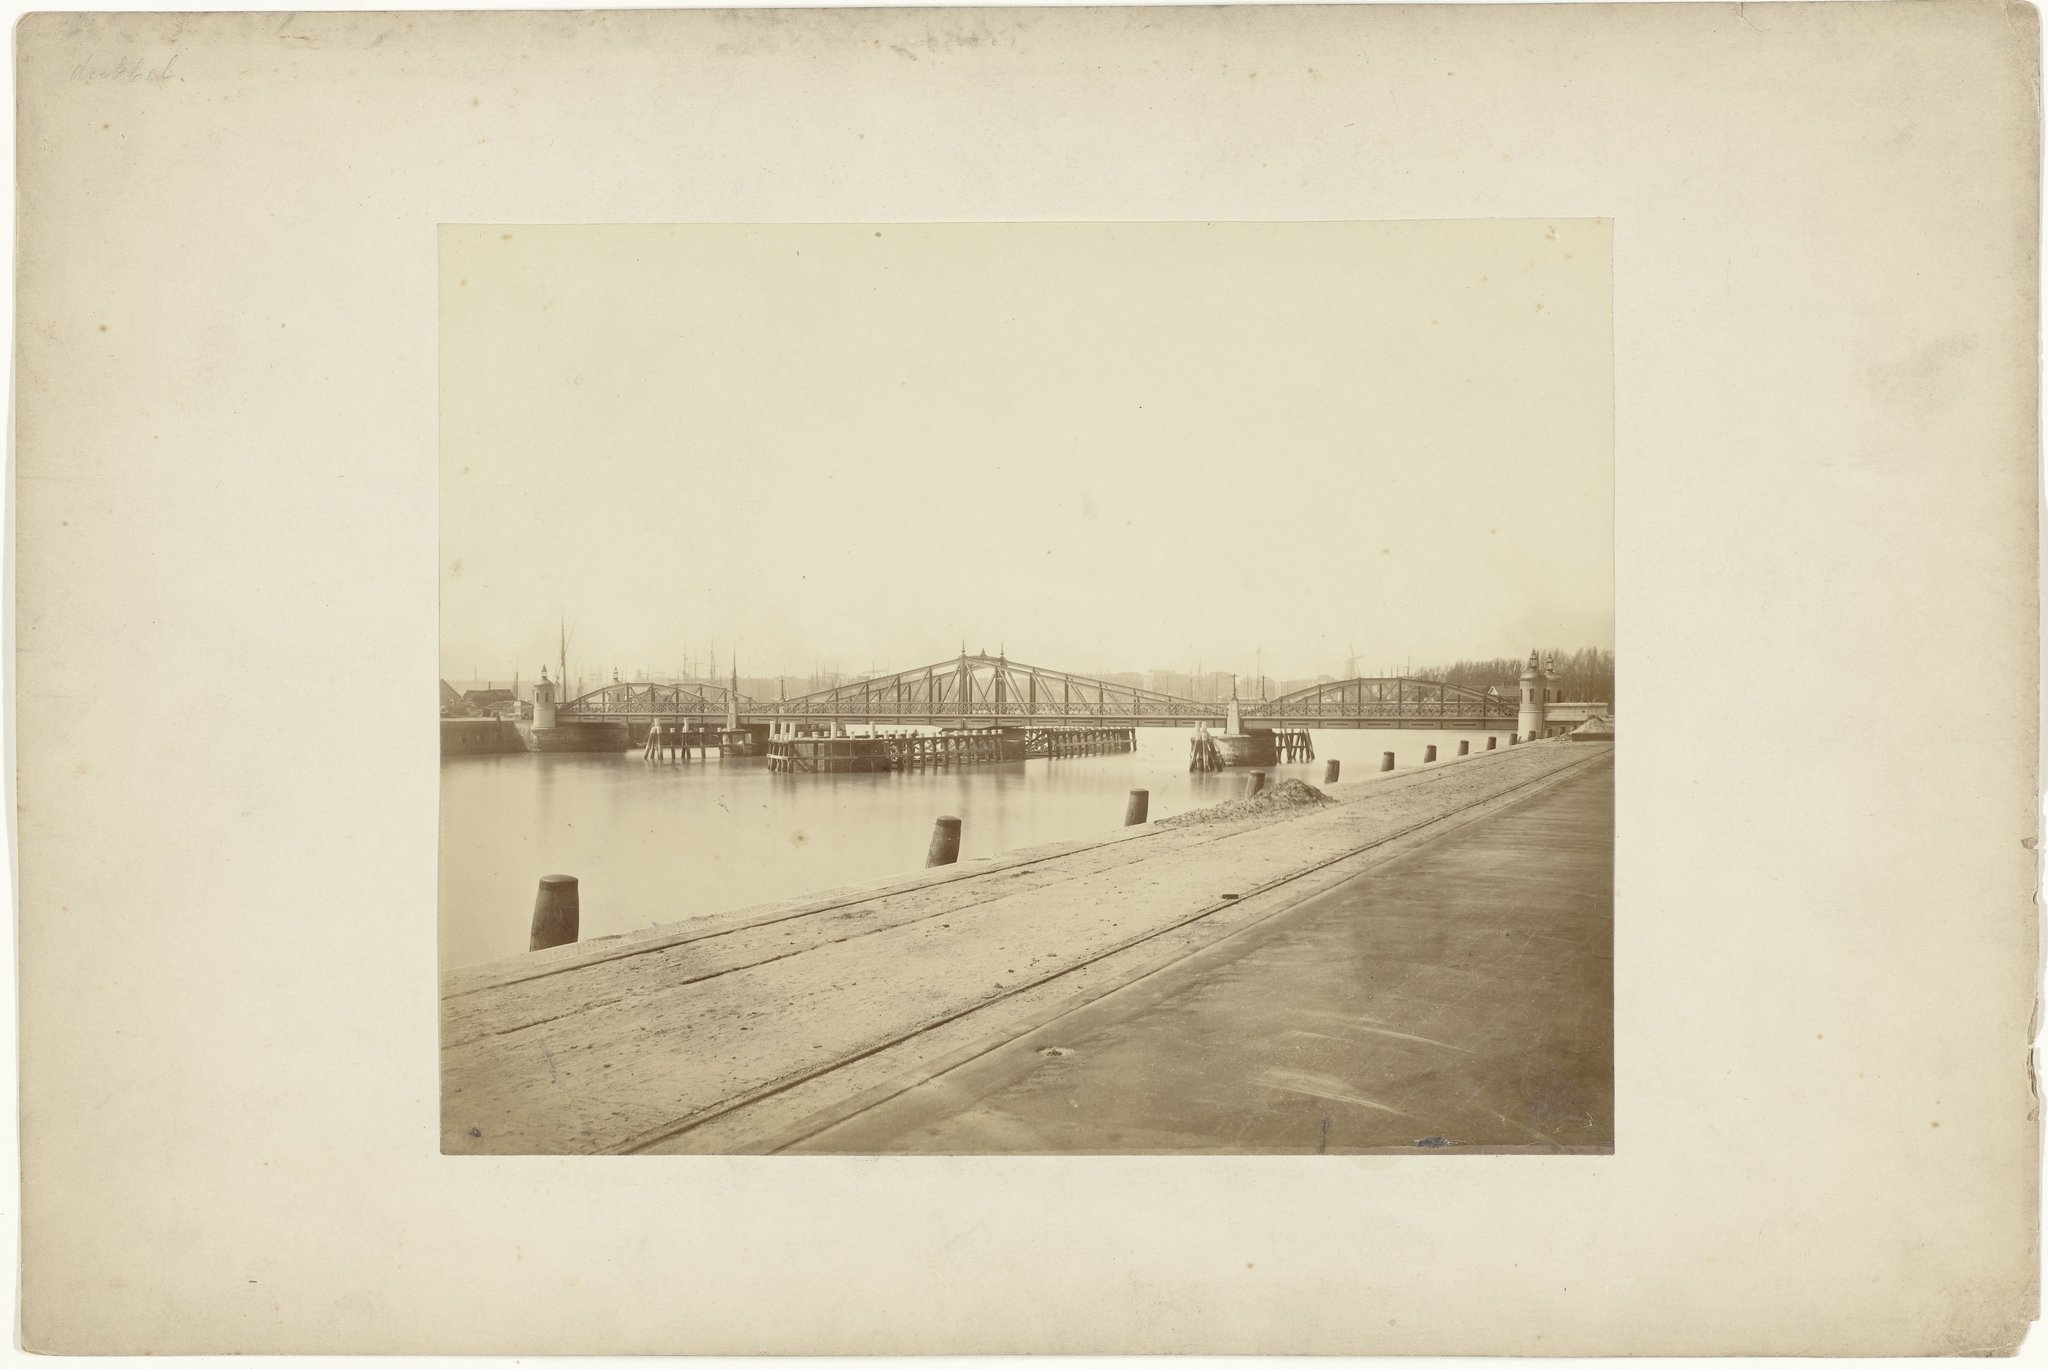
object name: photograph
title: Koninginnebrug over de Spoorweghaven in Rotterdam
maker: Anonymous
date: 1870-1890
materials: paper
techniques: albumen print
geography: rotterdam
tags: bridge in city across river, canal, etc.